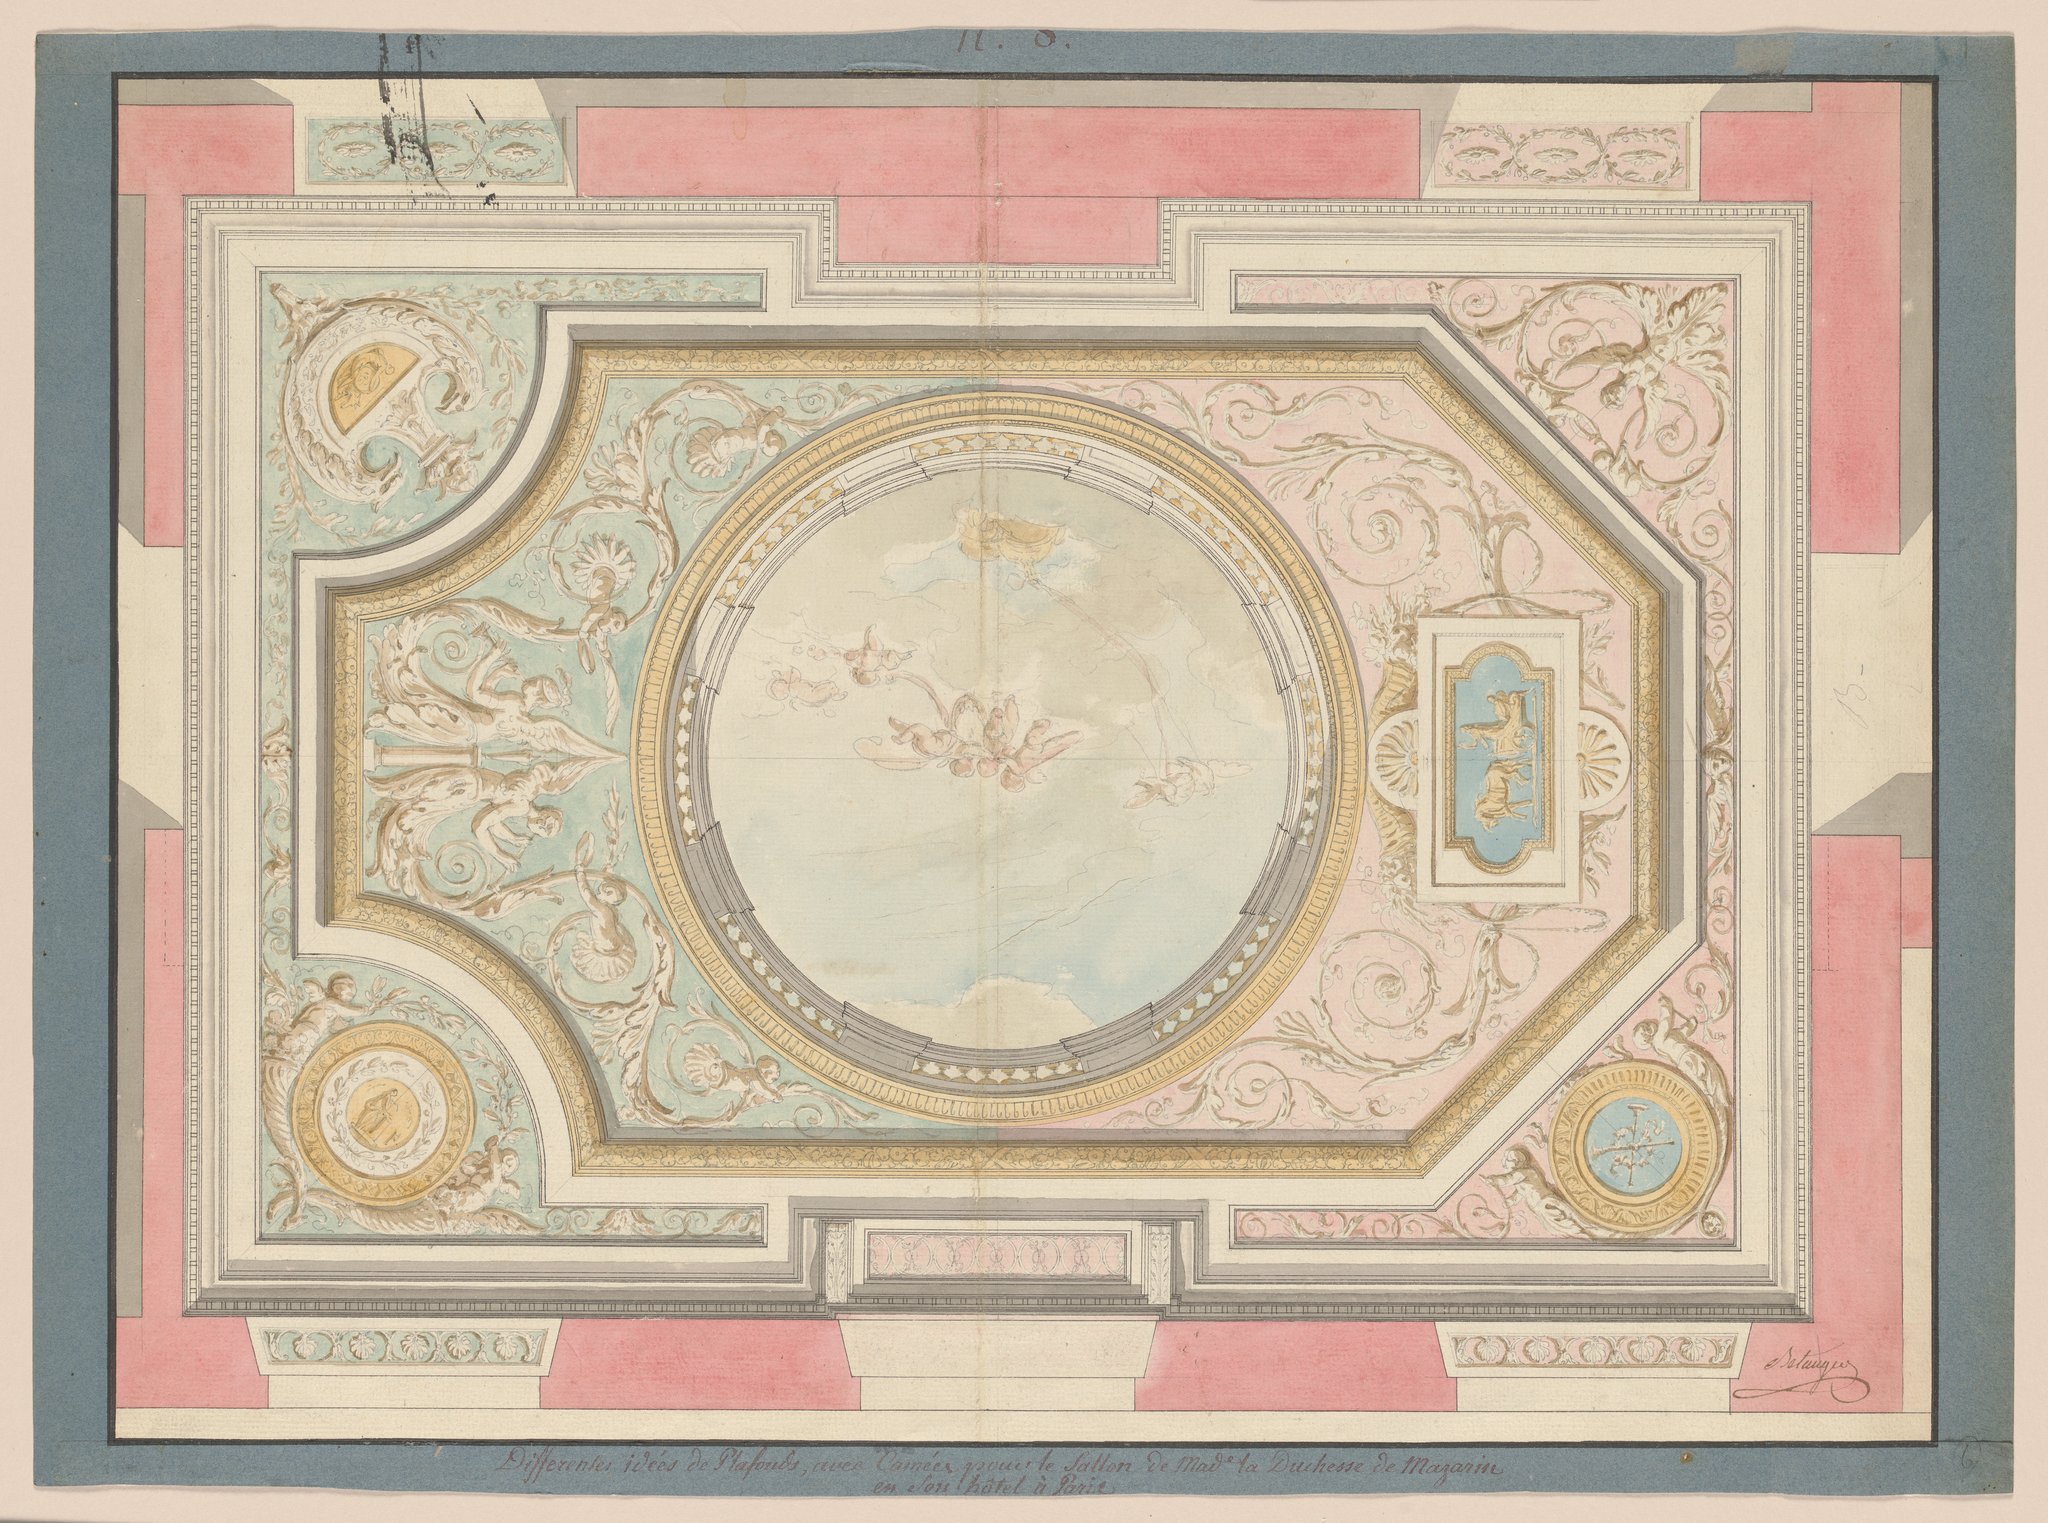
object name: ornament architecture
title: Study for a Ceiling of a Salon in the Hôtel de Mazarin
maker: françois joseph belanger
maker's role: artist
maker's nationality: french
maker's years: 1744-1818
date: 1780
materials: chalk, ink, paper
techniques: brush, drawing, pen, wash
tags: ceilings